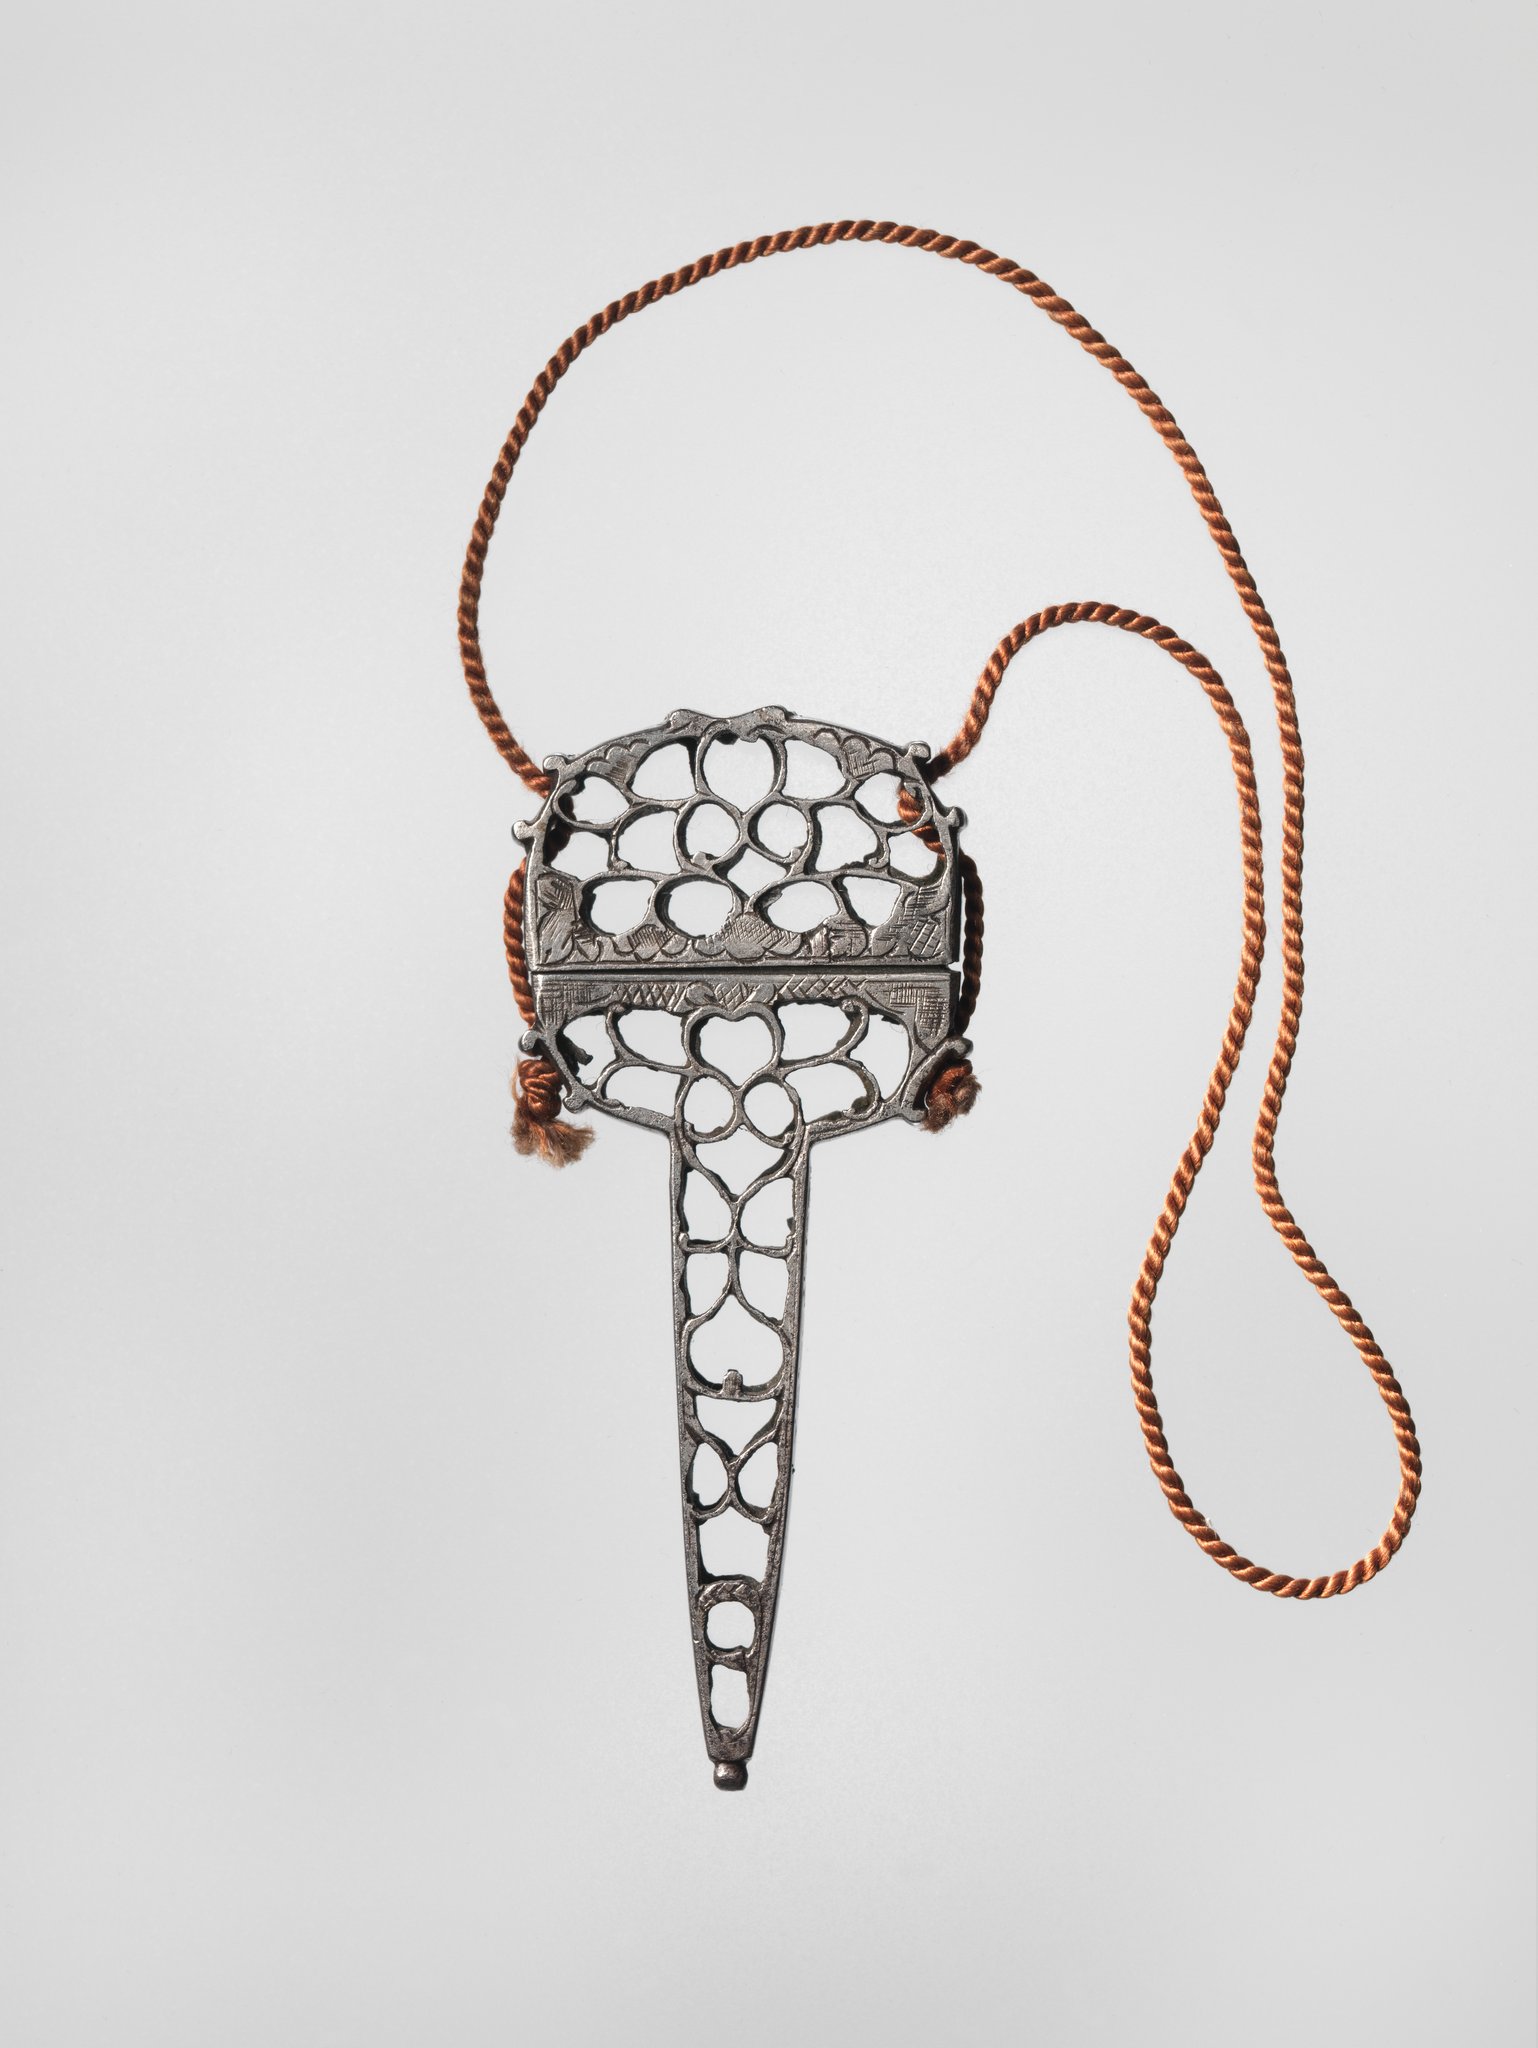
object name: scissors case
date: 1601-1700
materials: steel